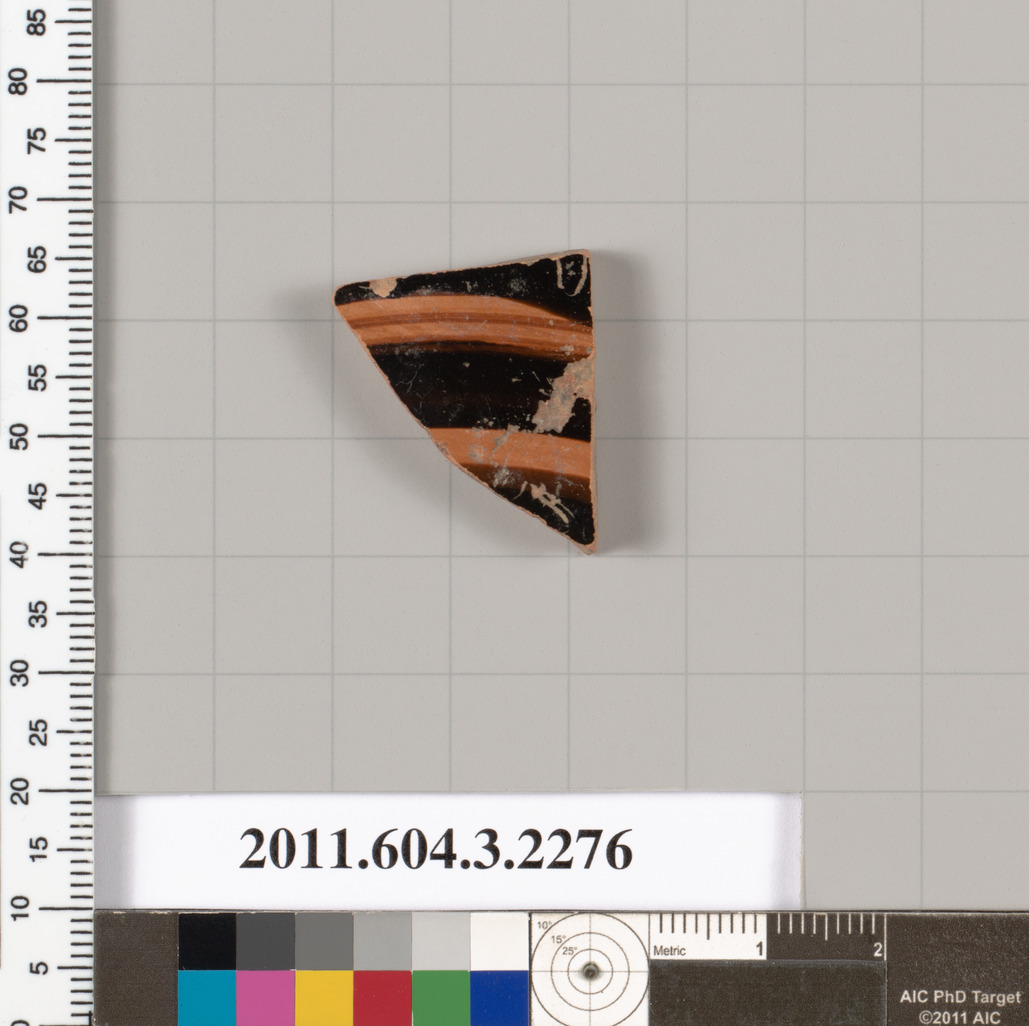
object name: kylix fragment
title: Terracotta fragment of a kylix (drinking cup)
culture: greek, attic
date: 600-401 BCE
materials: terracotta